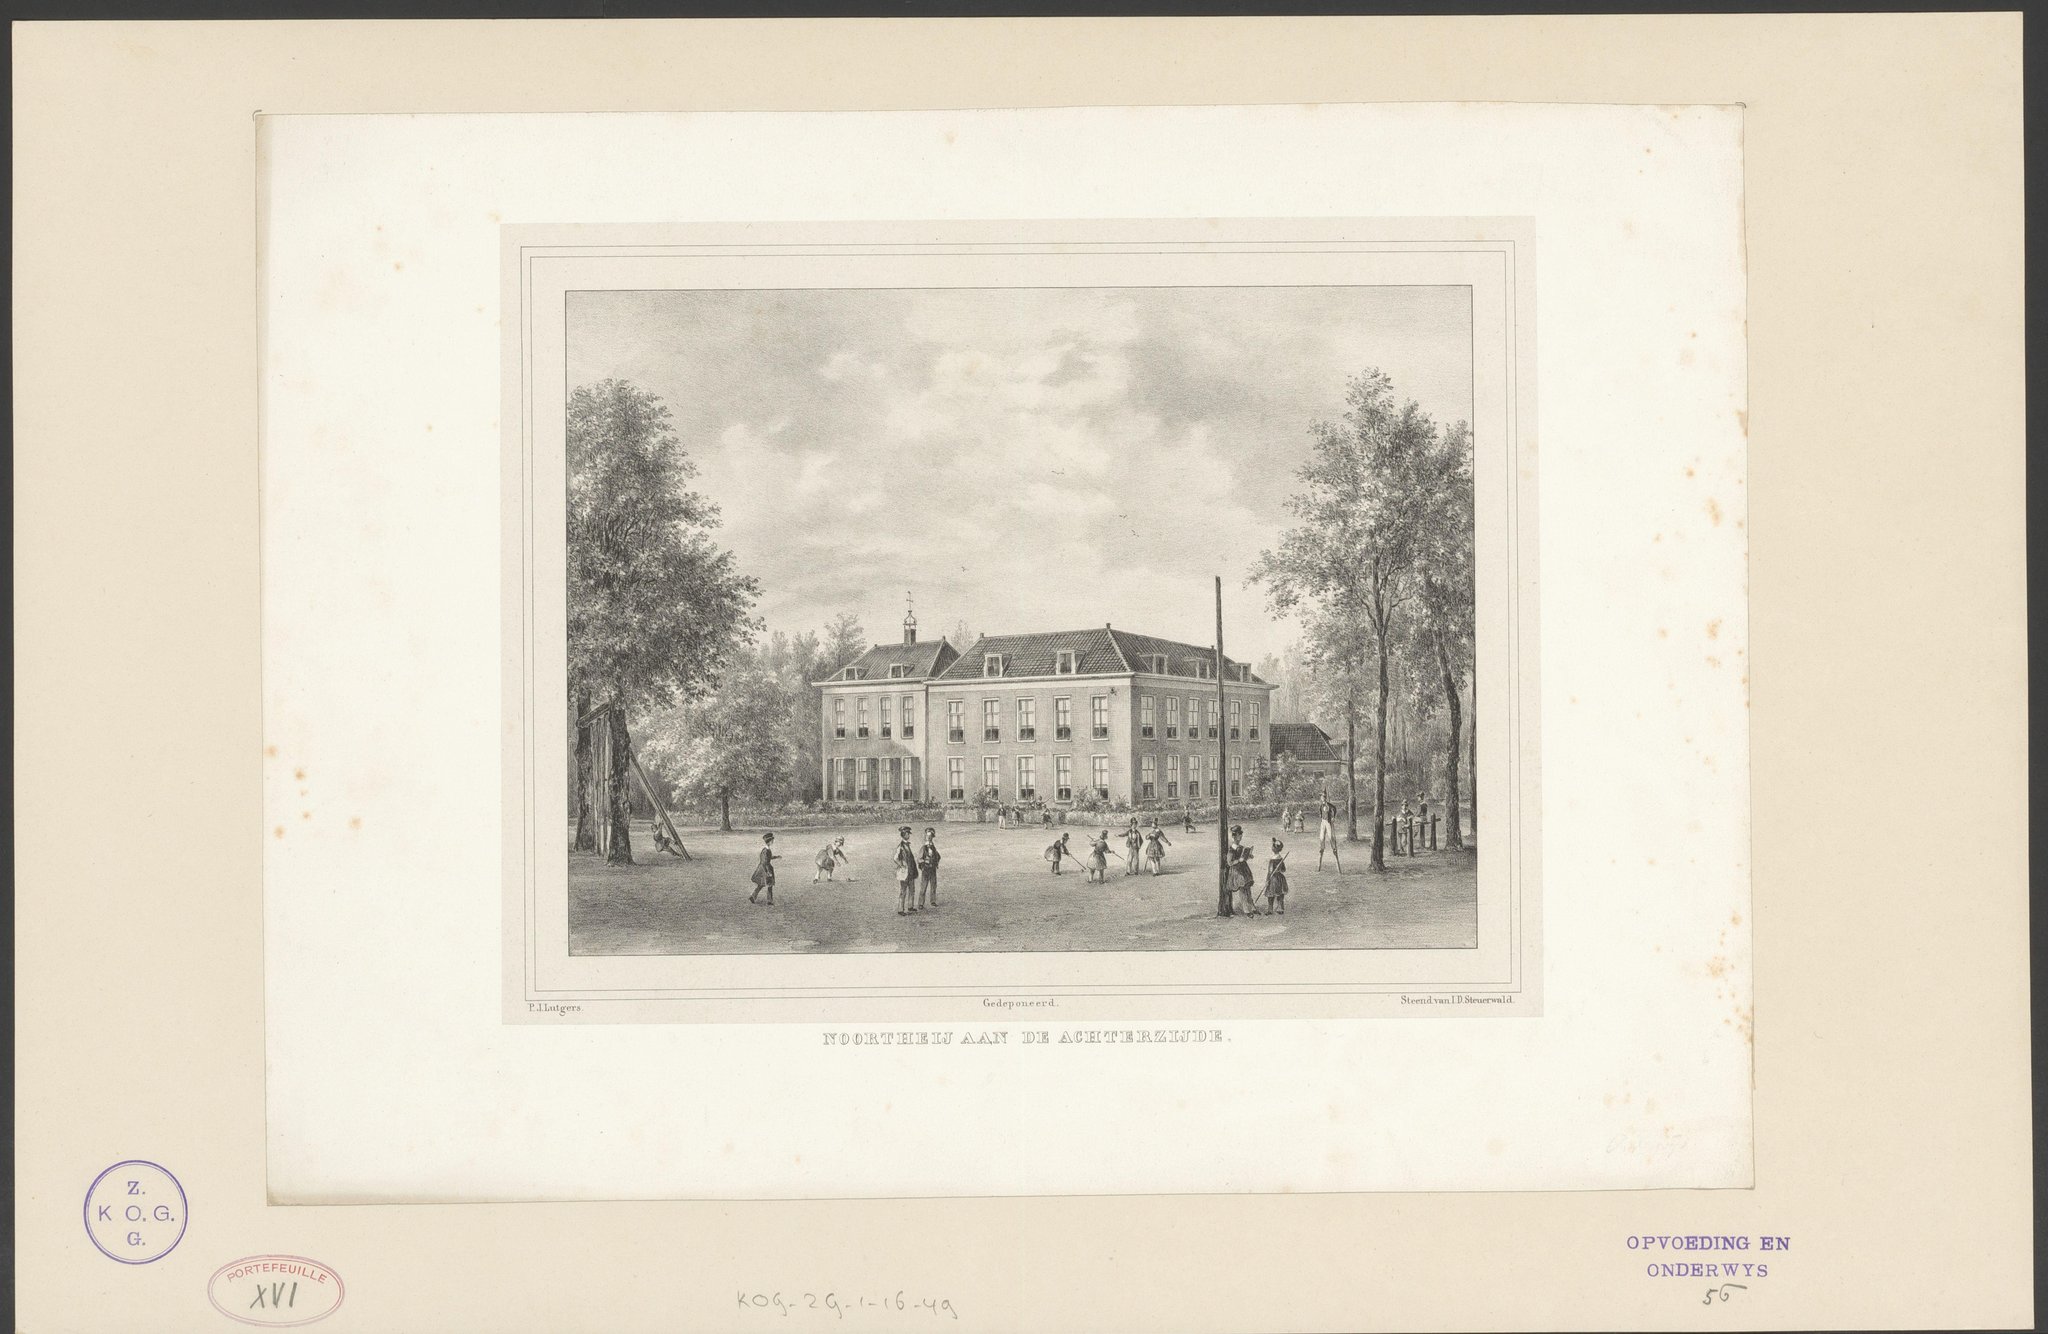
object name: print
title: Gezicht op Noorthey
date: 1855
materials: paper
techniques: lithograph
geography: the hague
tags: elementary school; class, form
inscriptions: collector's mark: Lugt 1641, stamp, stamp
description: Onderwerpsrubrieken binnen de Atlas Zeden en Gewoonten: Onderwijs en Wetenschappen, Opvoeding en Onderwijs, Gebouwen voor het onderwijs bestemd.